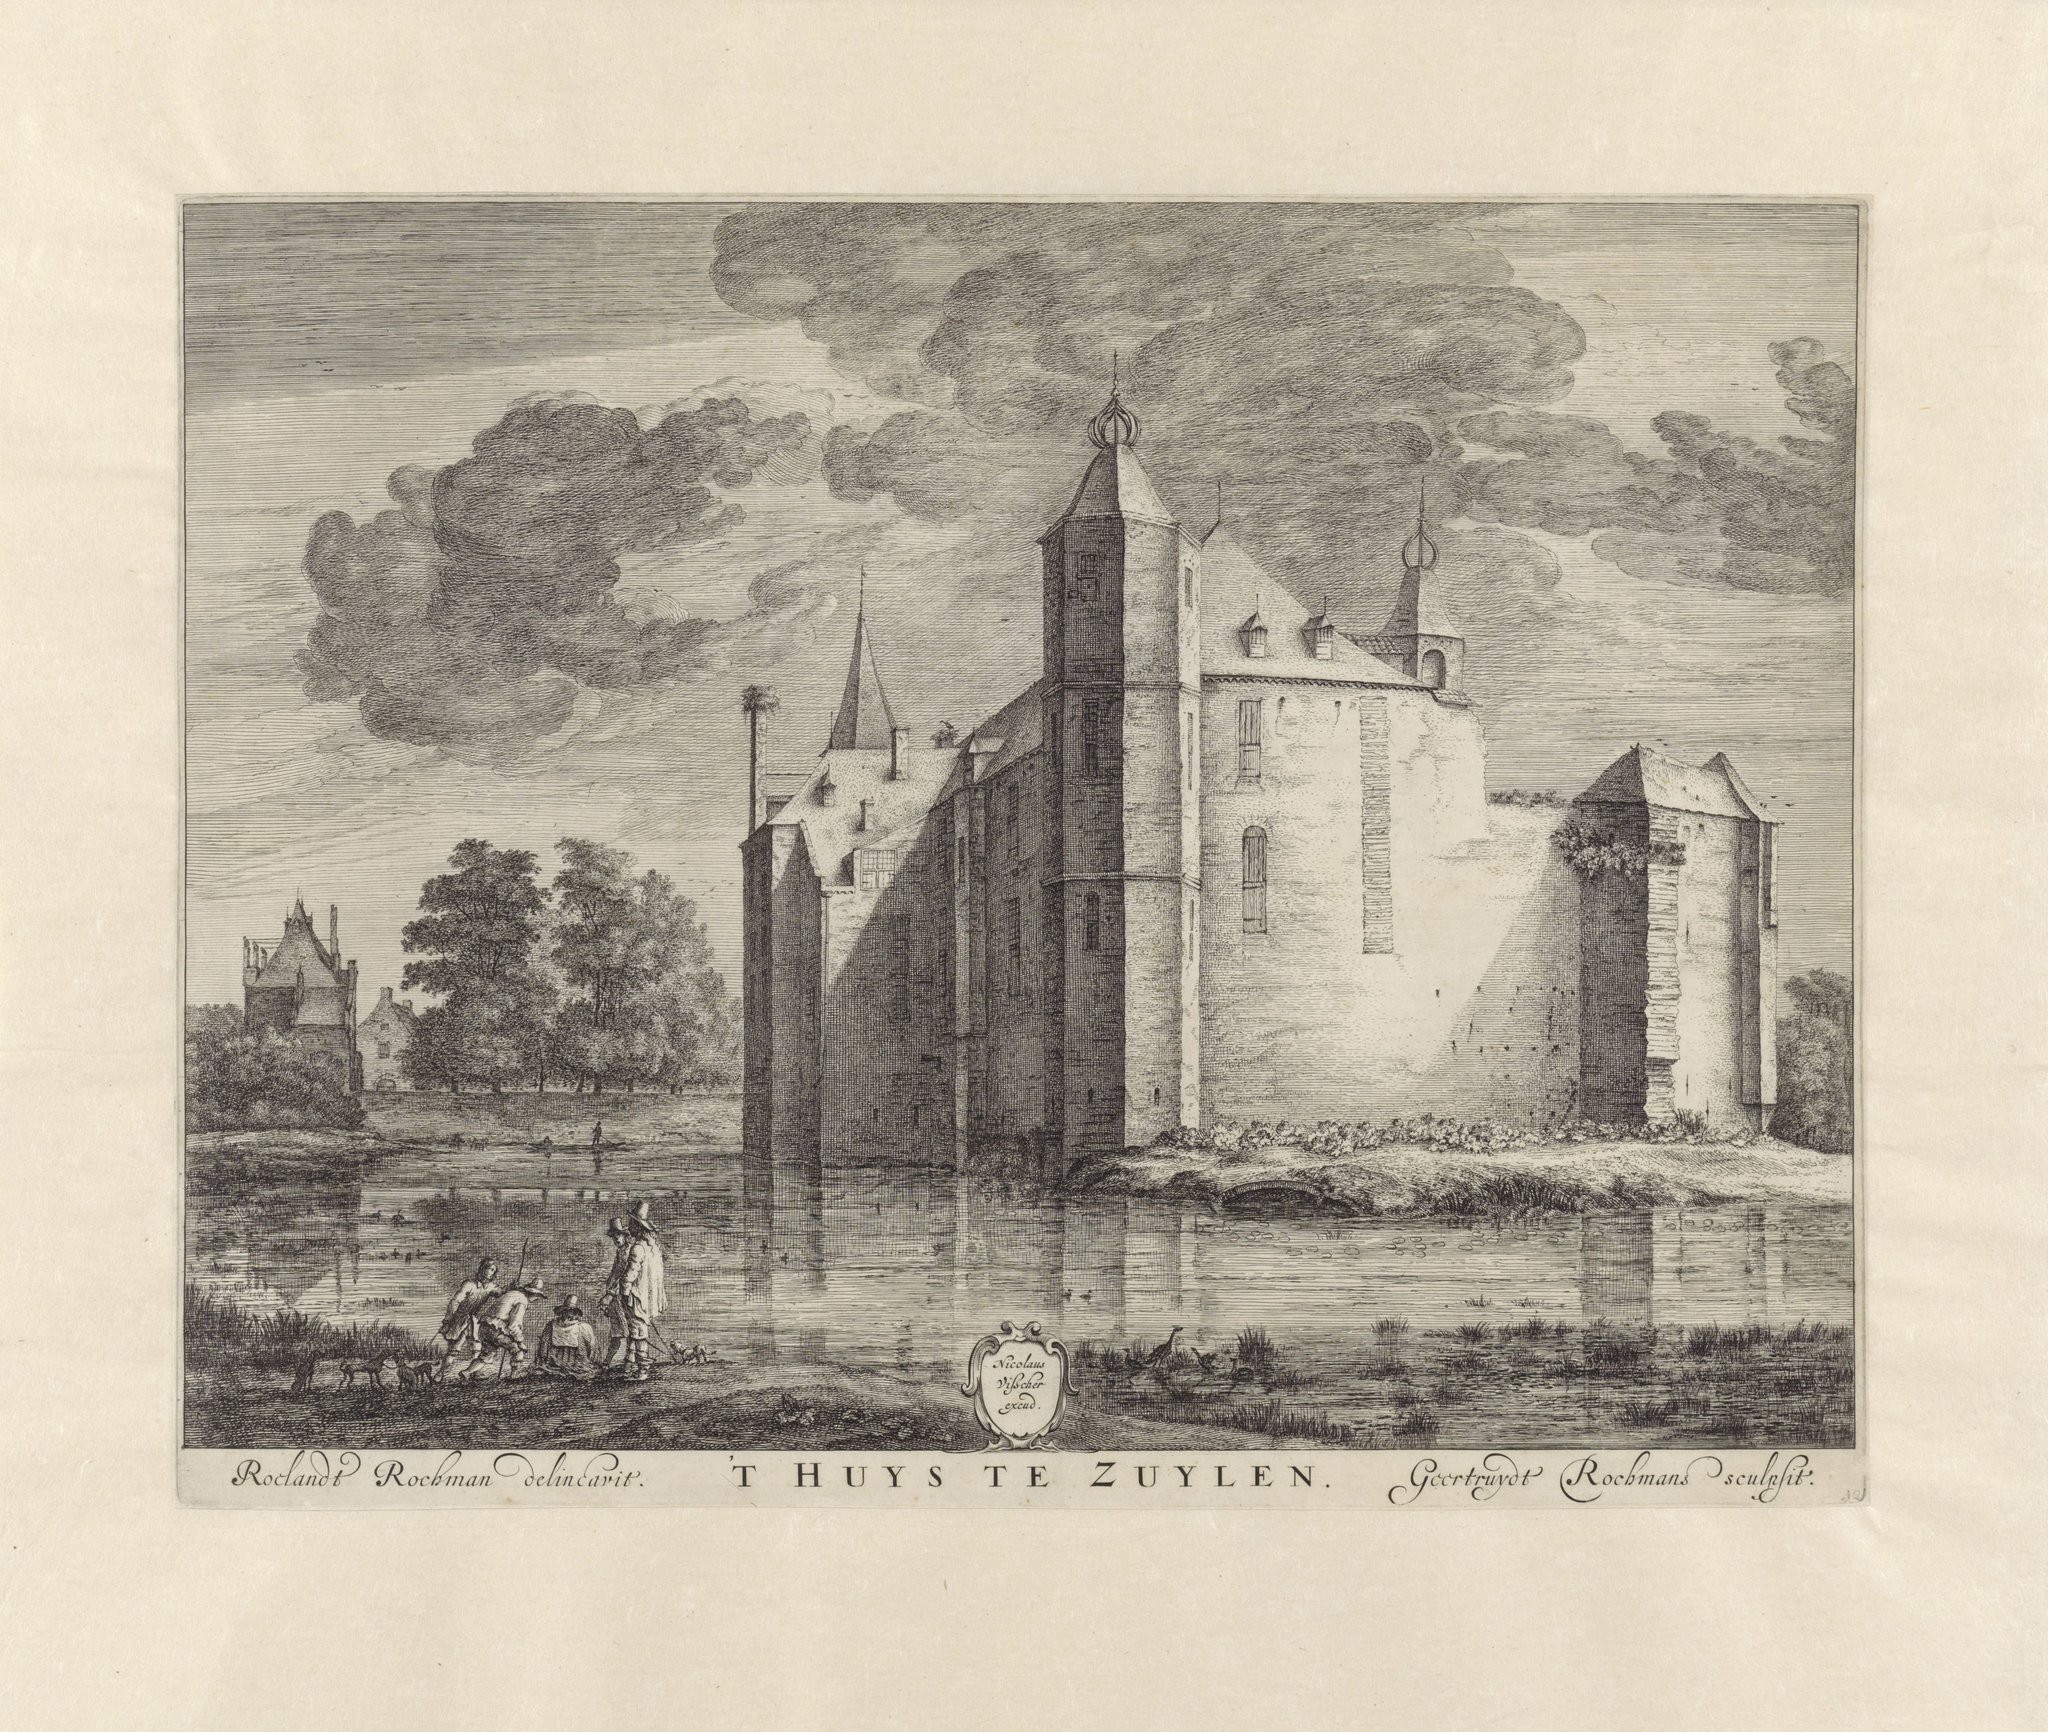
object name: print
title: Gezicht op het Huis Zuilen bij Maarssen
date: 1635-1709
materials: paper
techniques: engraving, etching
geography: amsterdam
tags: castle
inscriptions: collector's mark: Lugt 2228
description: Gezicht op het Huis Zuilen bij Maarssen, omgeven door een gracht. Op de voorgrond een groep van mannen en jongens met honden.